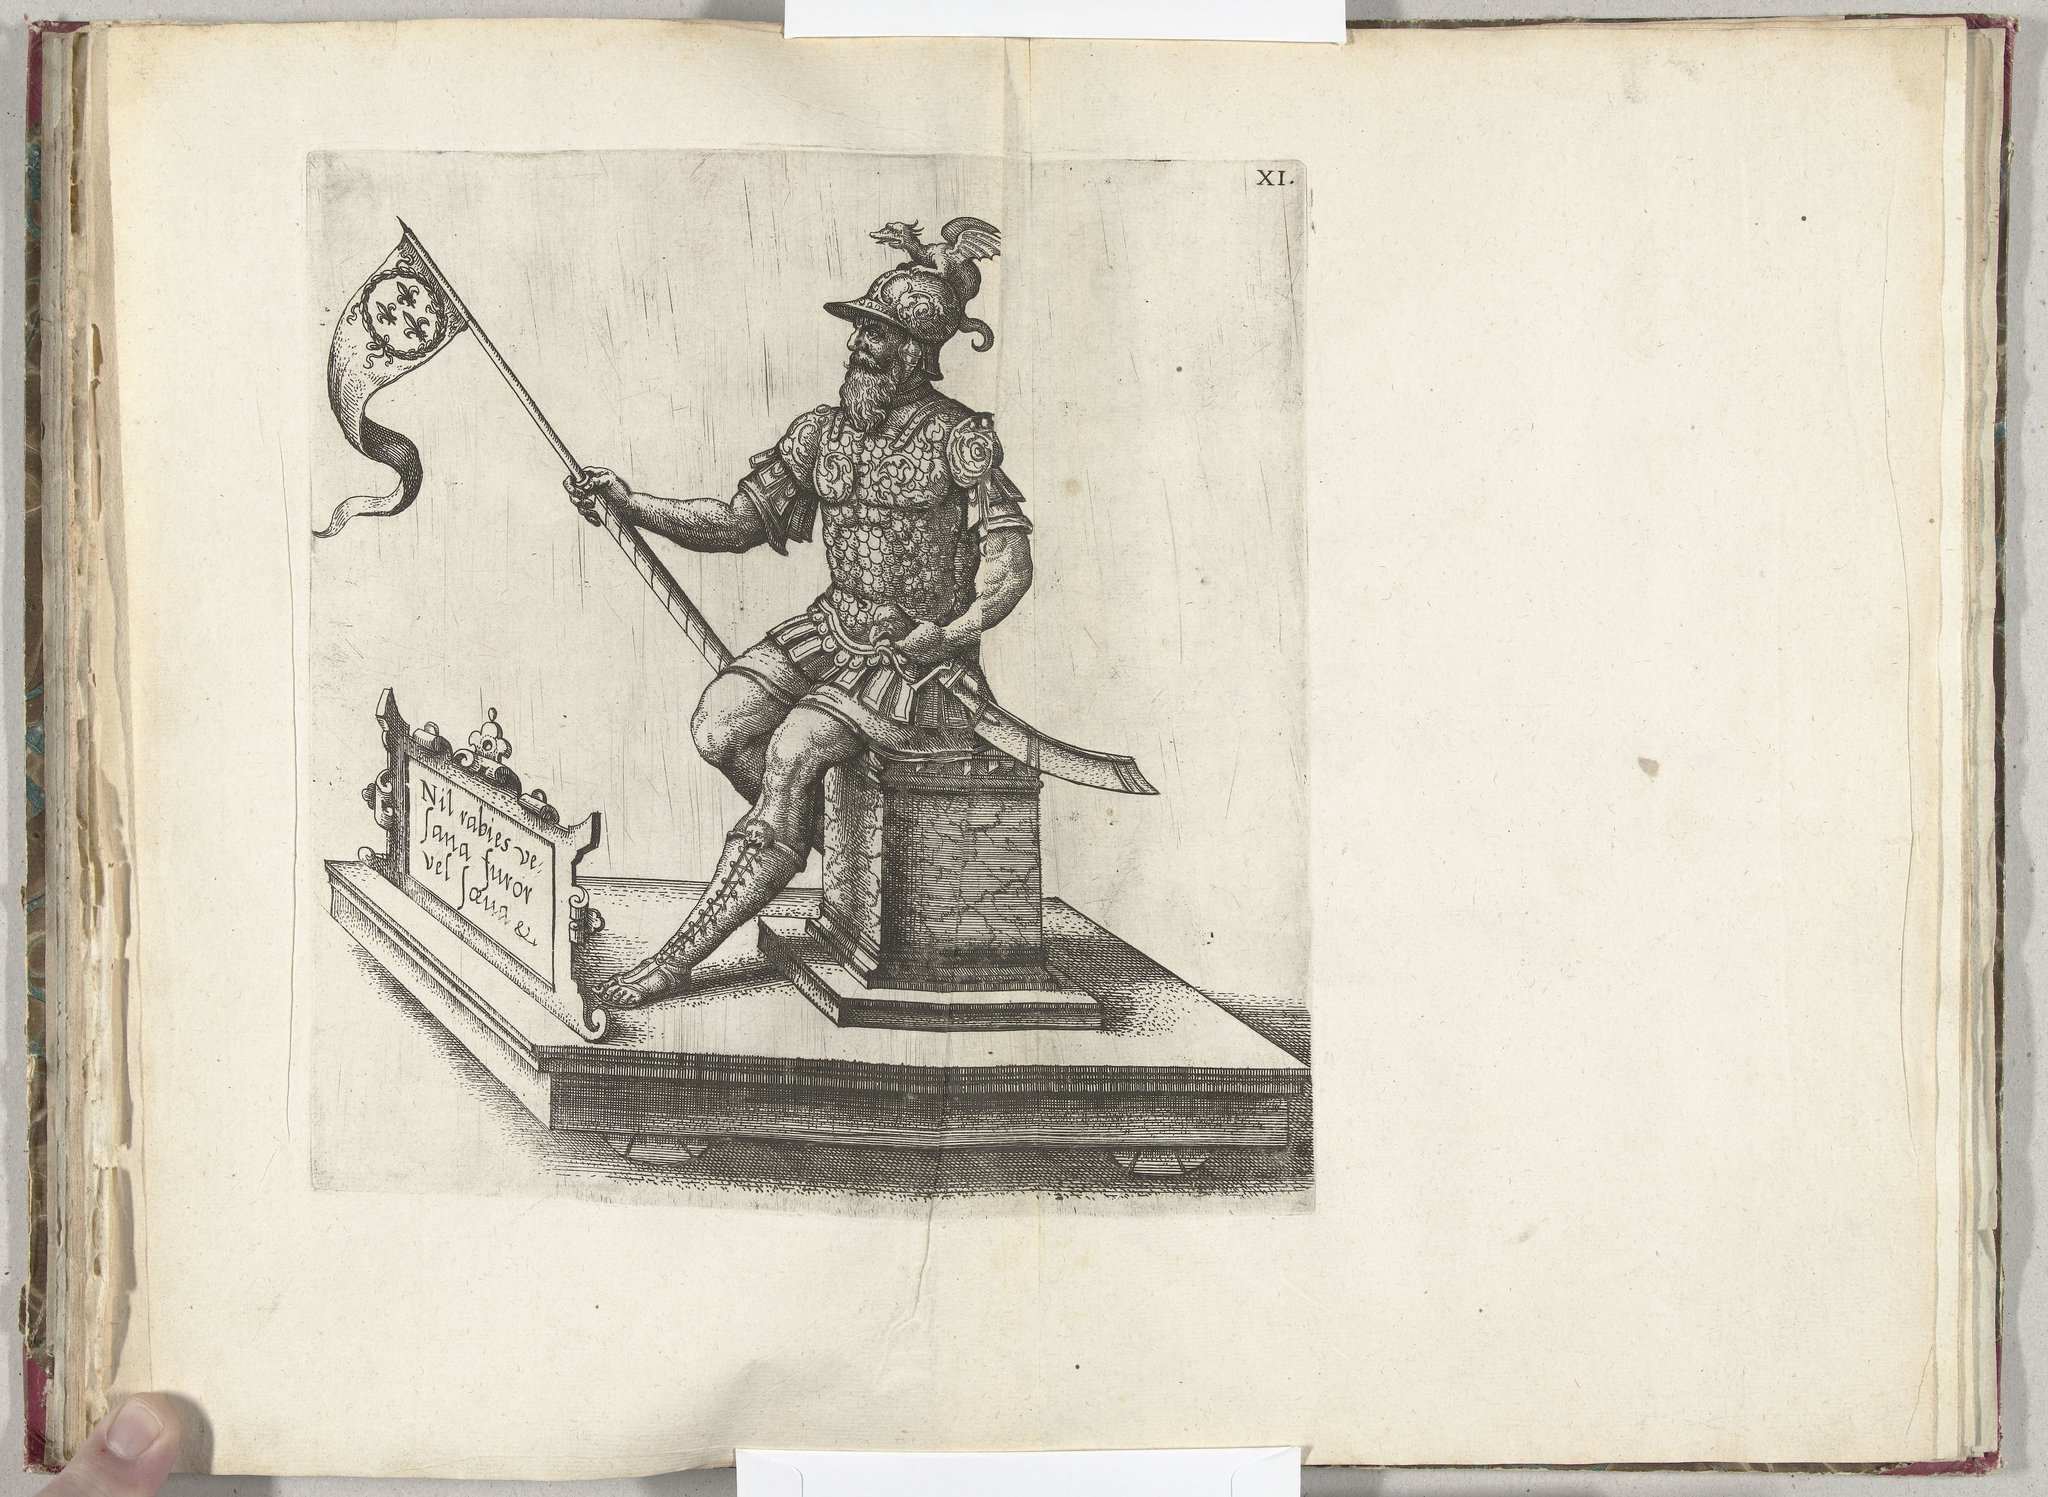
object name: print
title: Praalwagen met de reus Antigoon op de Grote Markt, 1582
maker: Anonymous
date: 1582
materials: paper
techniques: etching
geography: netherlands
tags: paris, françois-hercule de valois (hertog van anjou), float ~ triumph, triumphal entry and public reception, pageant, 'entrée solennelle', 'joyeuse entrée', giants, colossi, antwerp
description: Illustratie in: La ioyeuse et magnifique entrée de Françoys ... Duc de Brabant, d'Anjou, Alençon, Berri et c. en sa tres-renommée ville d'Anvers, Christoffel Plantijn, Antwerpen 1582, pl. XI. Boek in de Rijksmuseum Research Library met signatuur: 327 I 8.